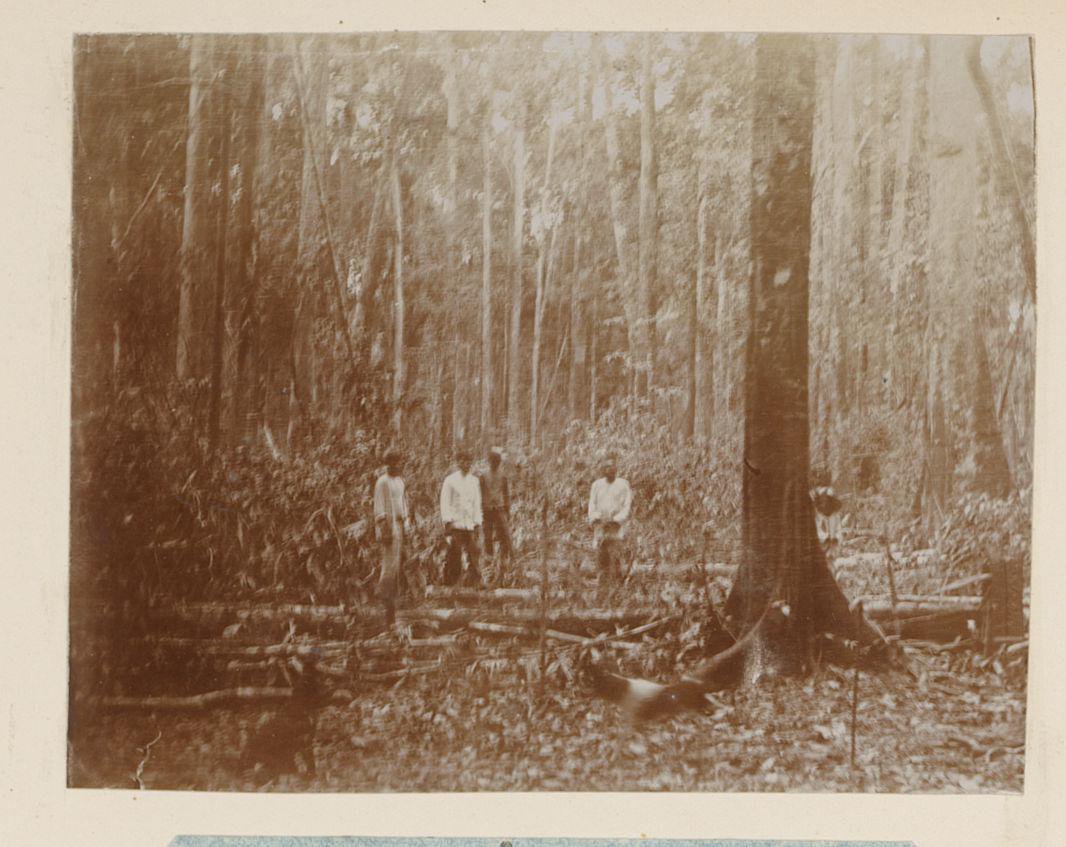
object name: photograph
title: Octobre 1910. Coupant du bois à Pernantian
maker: Anonymous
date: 1910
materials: photographic support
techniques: collodion silver print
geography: east sumatra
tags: plantation, (non-fruit) products of plants or trees: rubber, woodcutting, woodcutter ~ forestry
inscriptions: inscription: ‘Octobre 1910. Coupant du bois à Pernantian’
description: Het rooien van bos in 1910 voor de aanleg van de plantage. Onderdeel van het fotoalbum over de plantages Brussel en Pernantian van de Sumatra Caoutchouc Maatschappij op de Oostkust van Sumatra in de jaren 1910-1935.